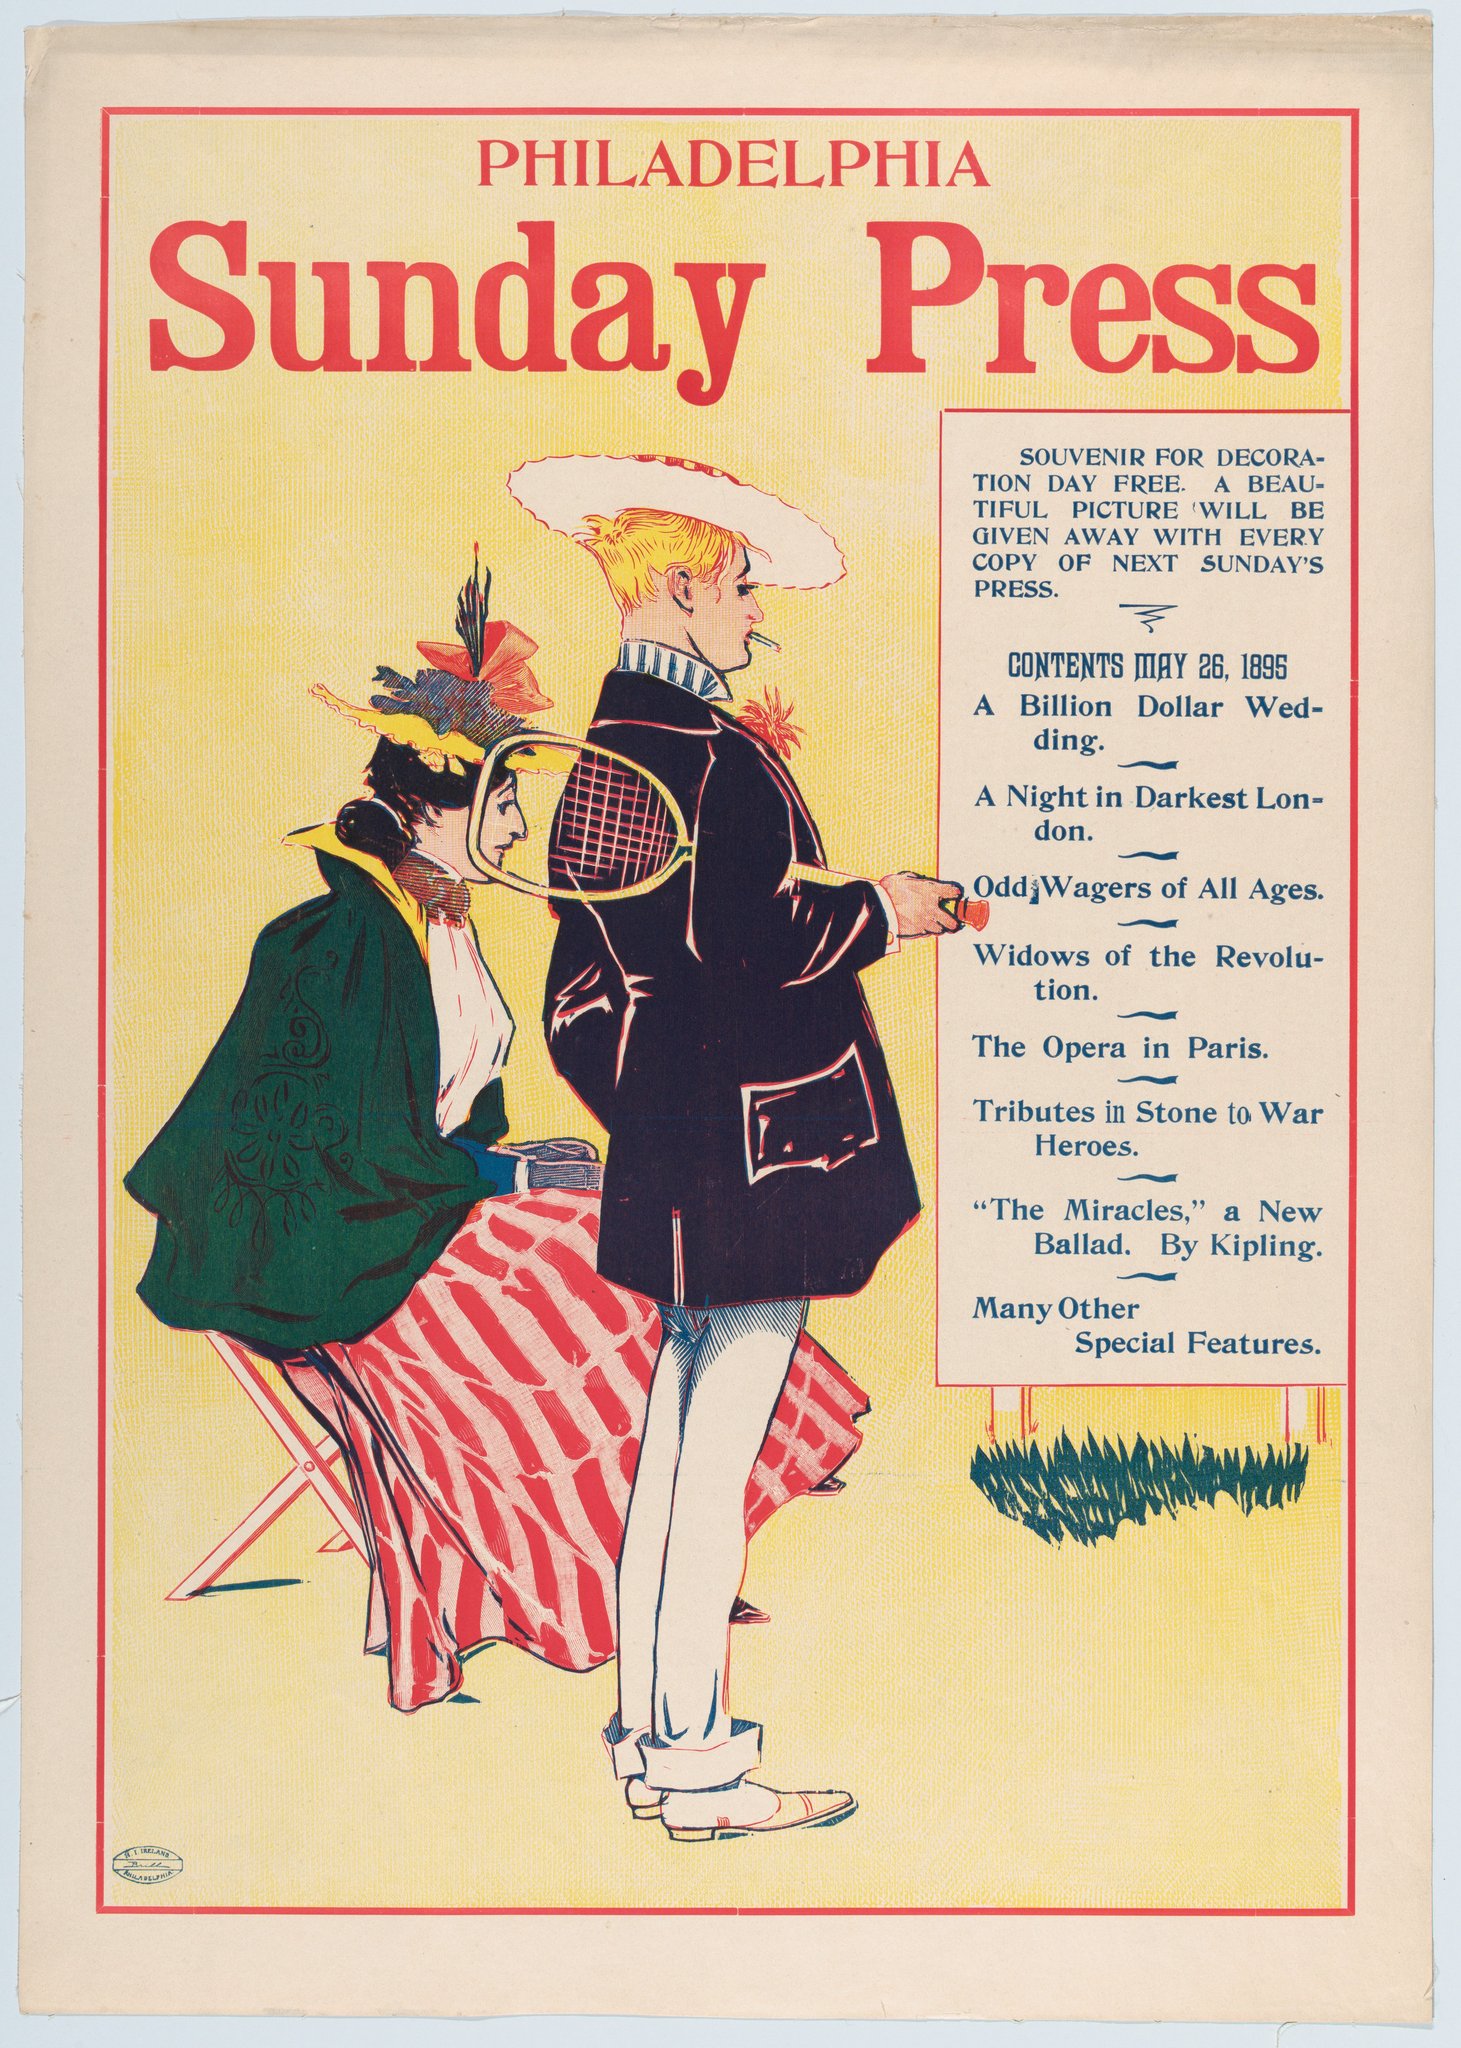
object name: print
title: Philadelphia Sunday Press, May 26, 1895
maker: george reiter brill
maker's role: artist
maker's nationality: american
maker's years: 1867-1918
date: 1895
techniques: lithograph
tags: men,women